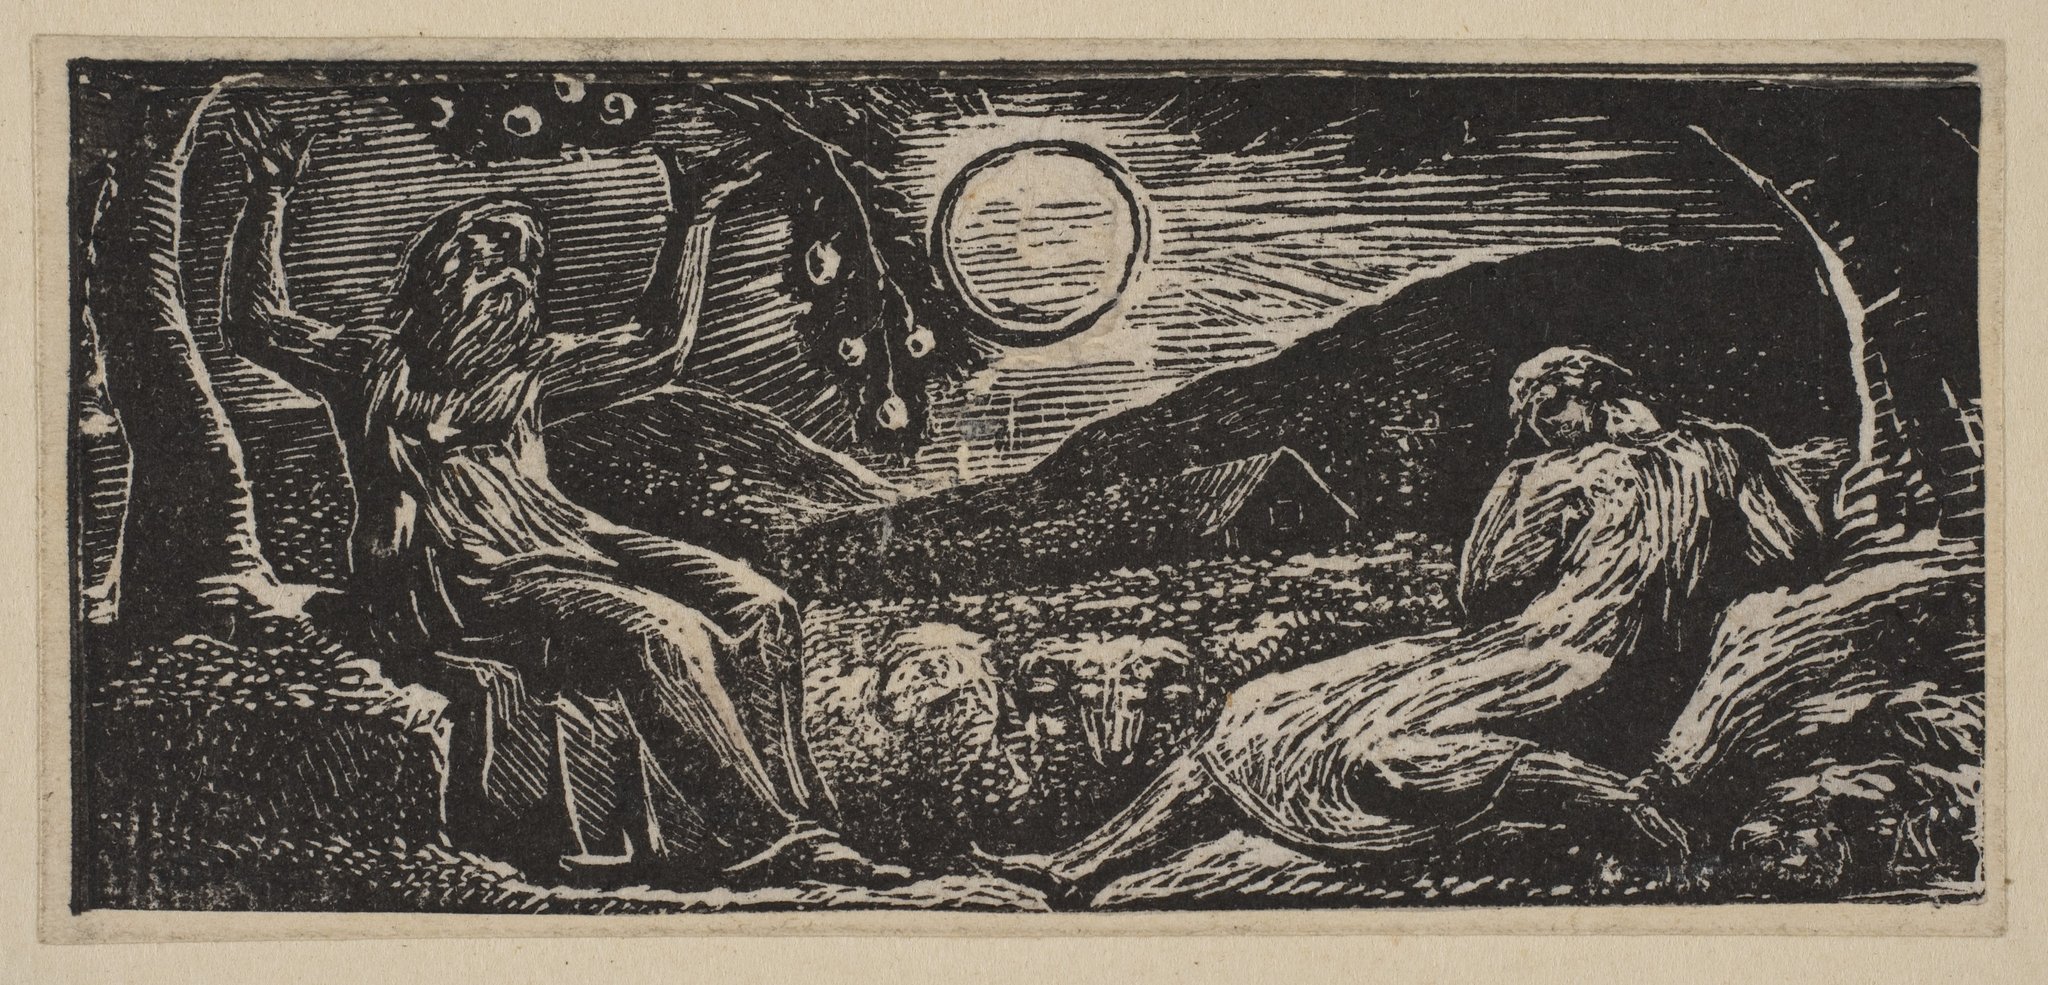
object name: print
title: Thenot Under a Fruit Tree, from Thornton's "Pastorals of Virgil"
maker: william blake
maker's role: artist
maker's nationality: british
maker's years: 1757-1827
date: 1821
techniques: engraving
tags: fruit,men,pastoral,trees